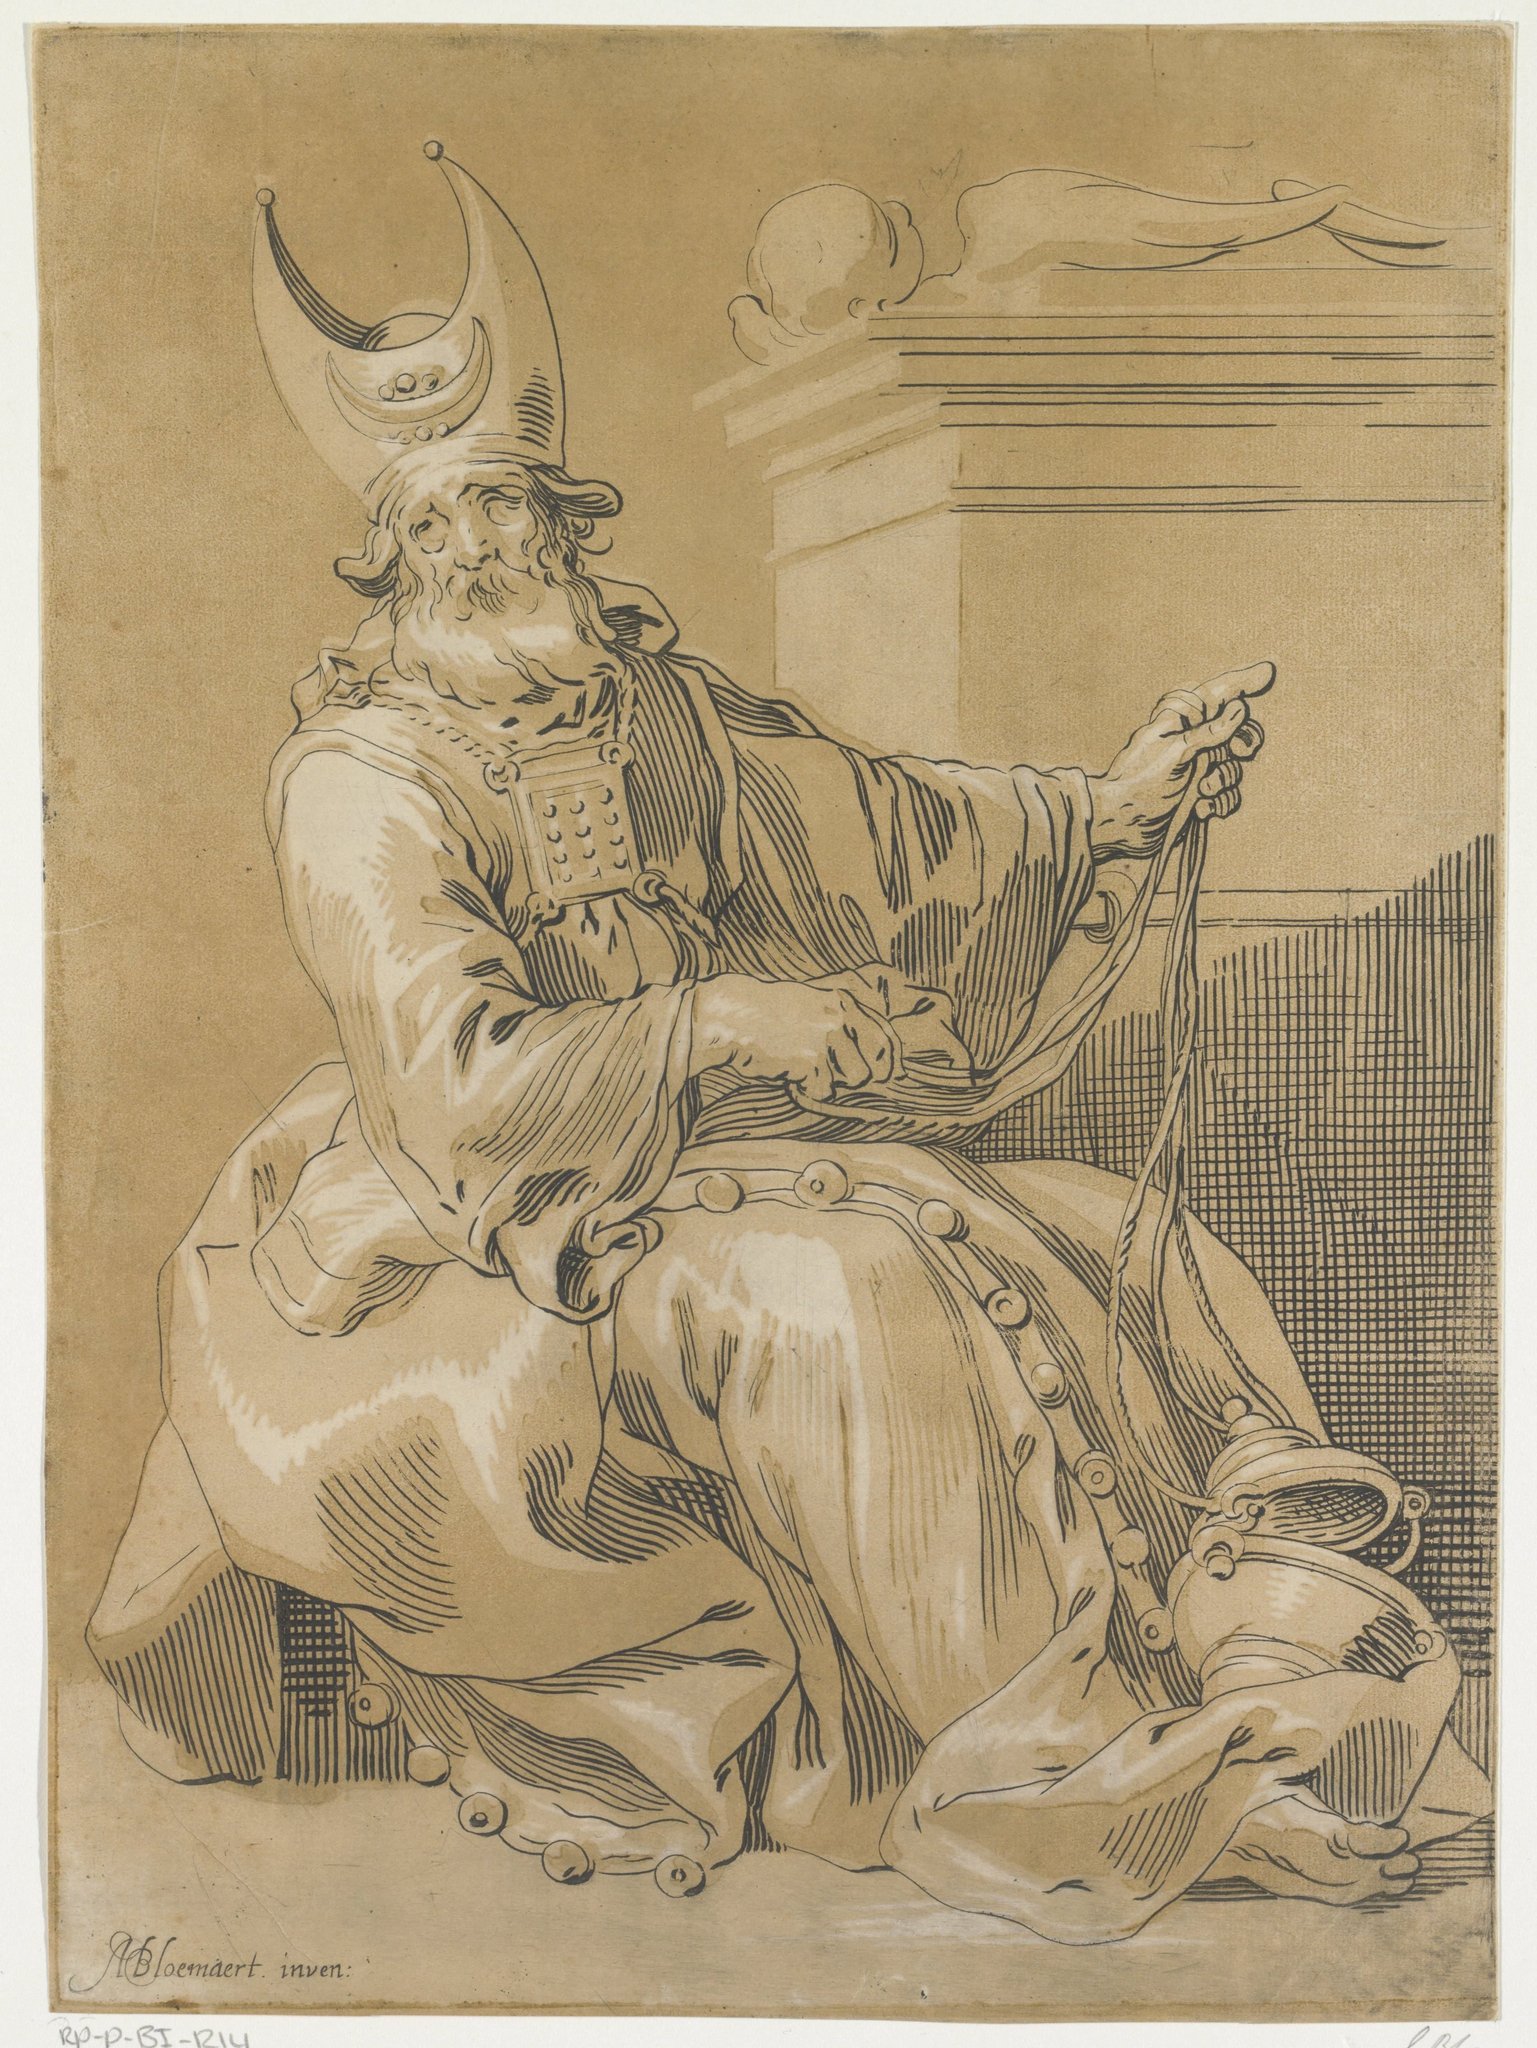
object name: print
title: Aäron zittend bij de Ark des Verbonds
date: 1610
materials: paper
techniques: woodcut, etching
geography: netherlands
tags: the tabernacle is set up and moses puts the ark with the tables in it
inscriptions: collector's mark: Lugt 240